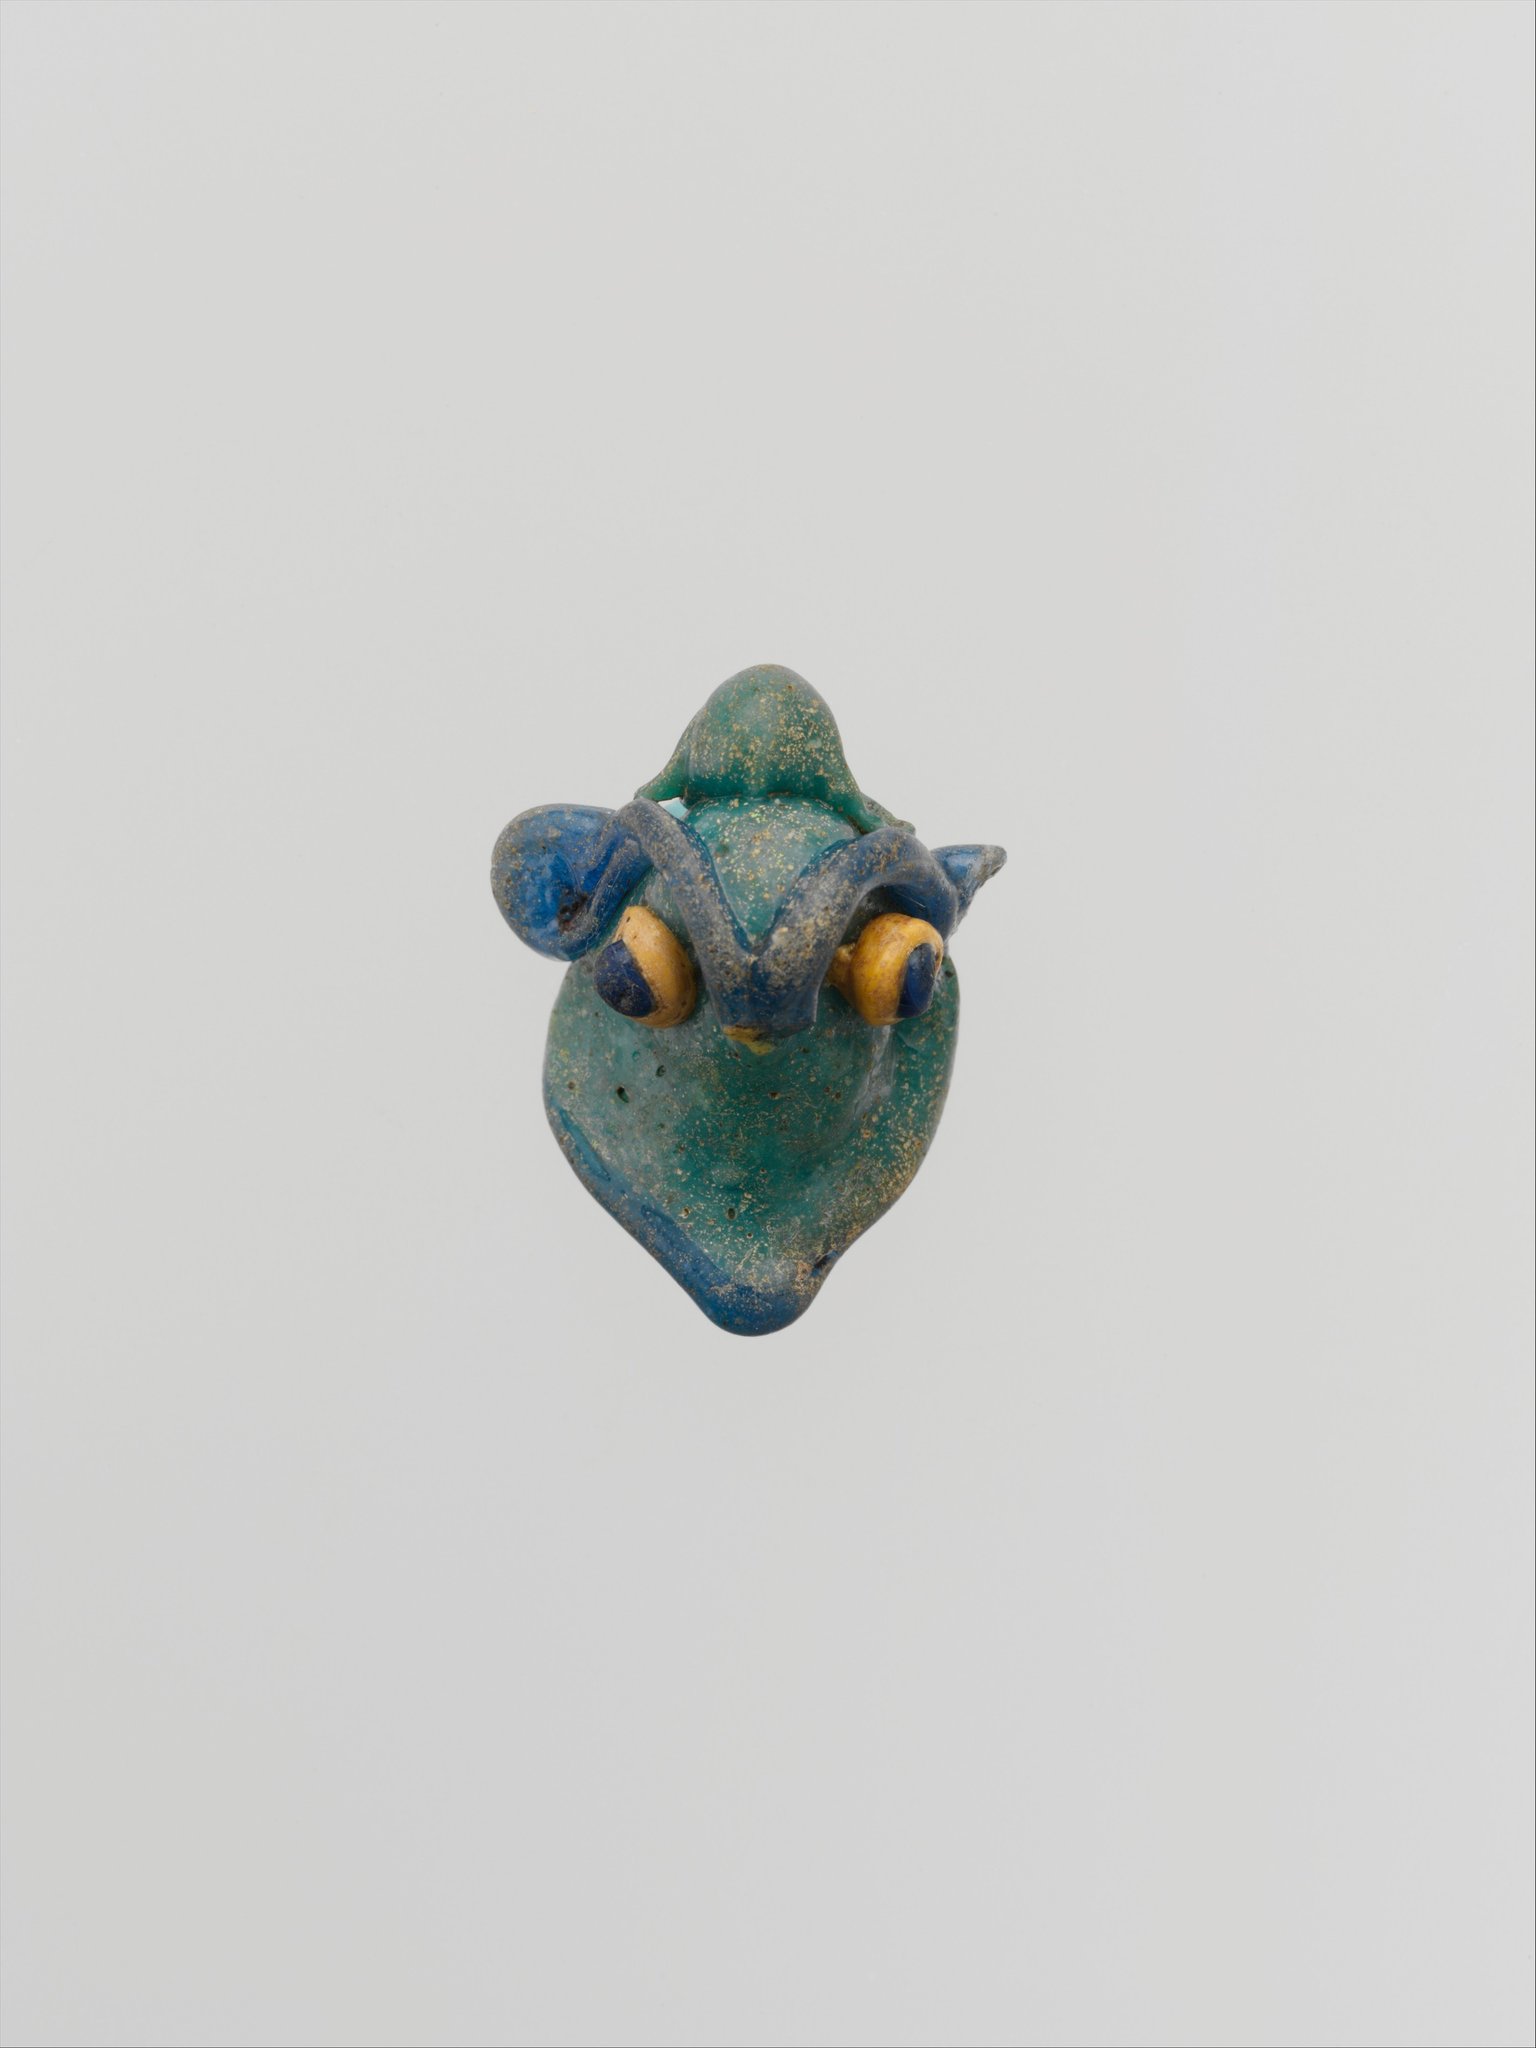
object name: head pendant of a demon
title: Glass pendant in the form of a demonic mask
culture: phoenician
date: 600-401 BCE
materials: glass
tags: masks